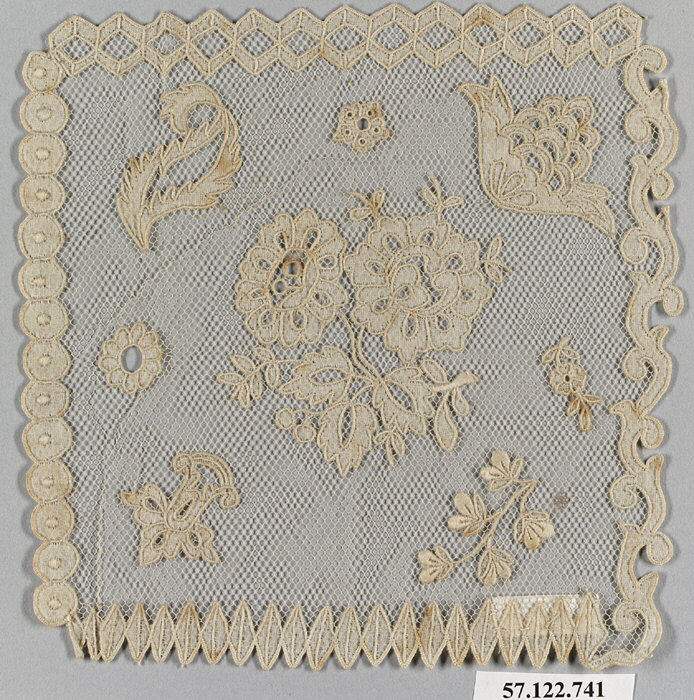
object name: sampler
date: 1801-1900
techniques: embroidery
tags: flowers